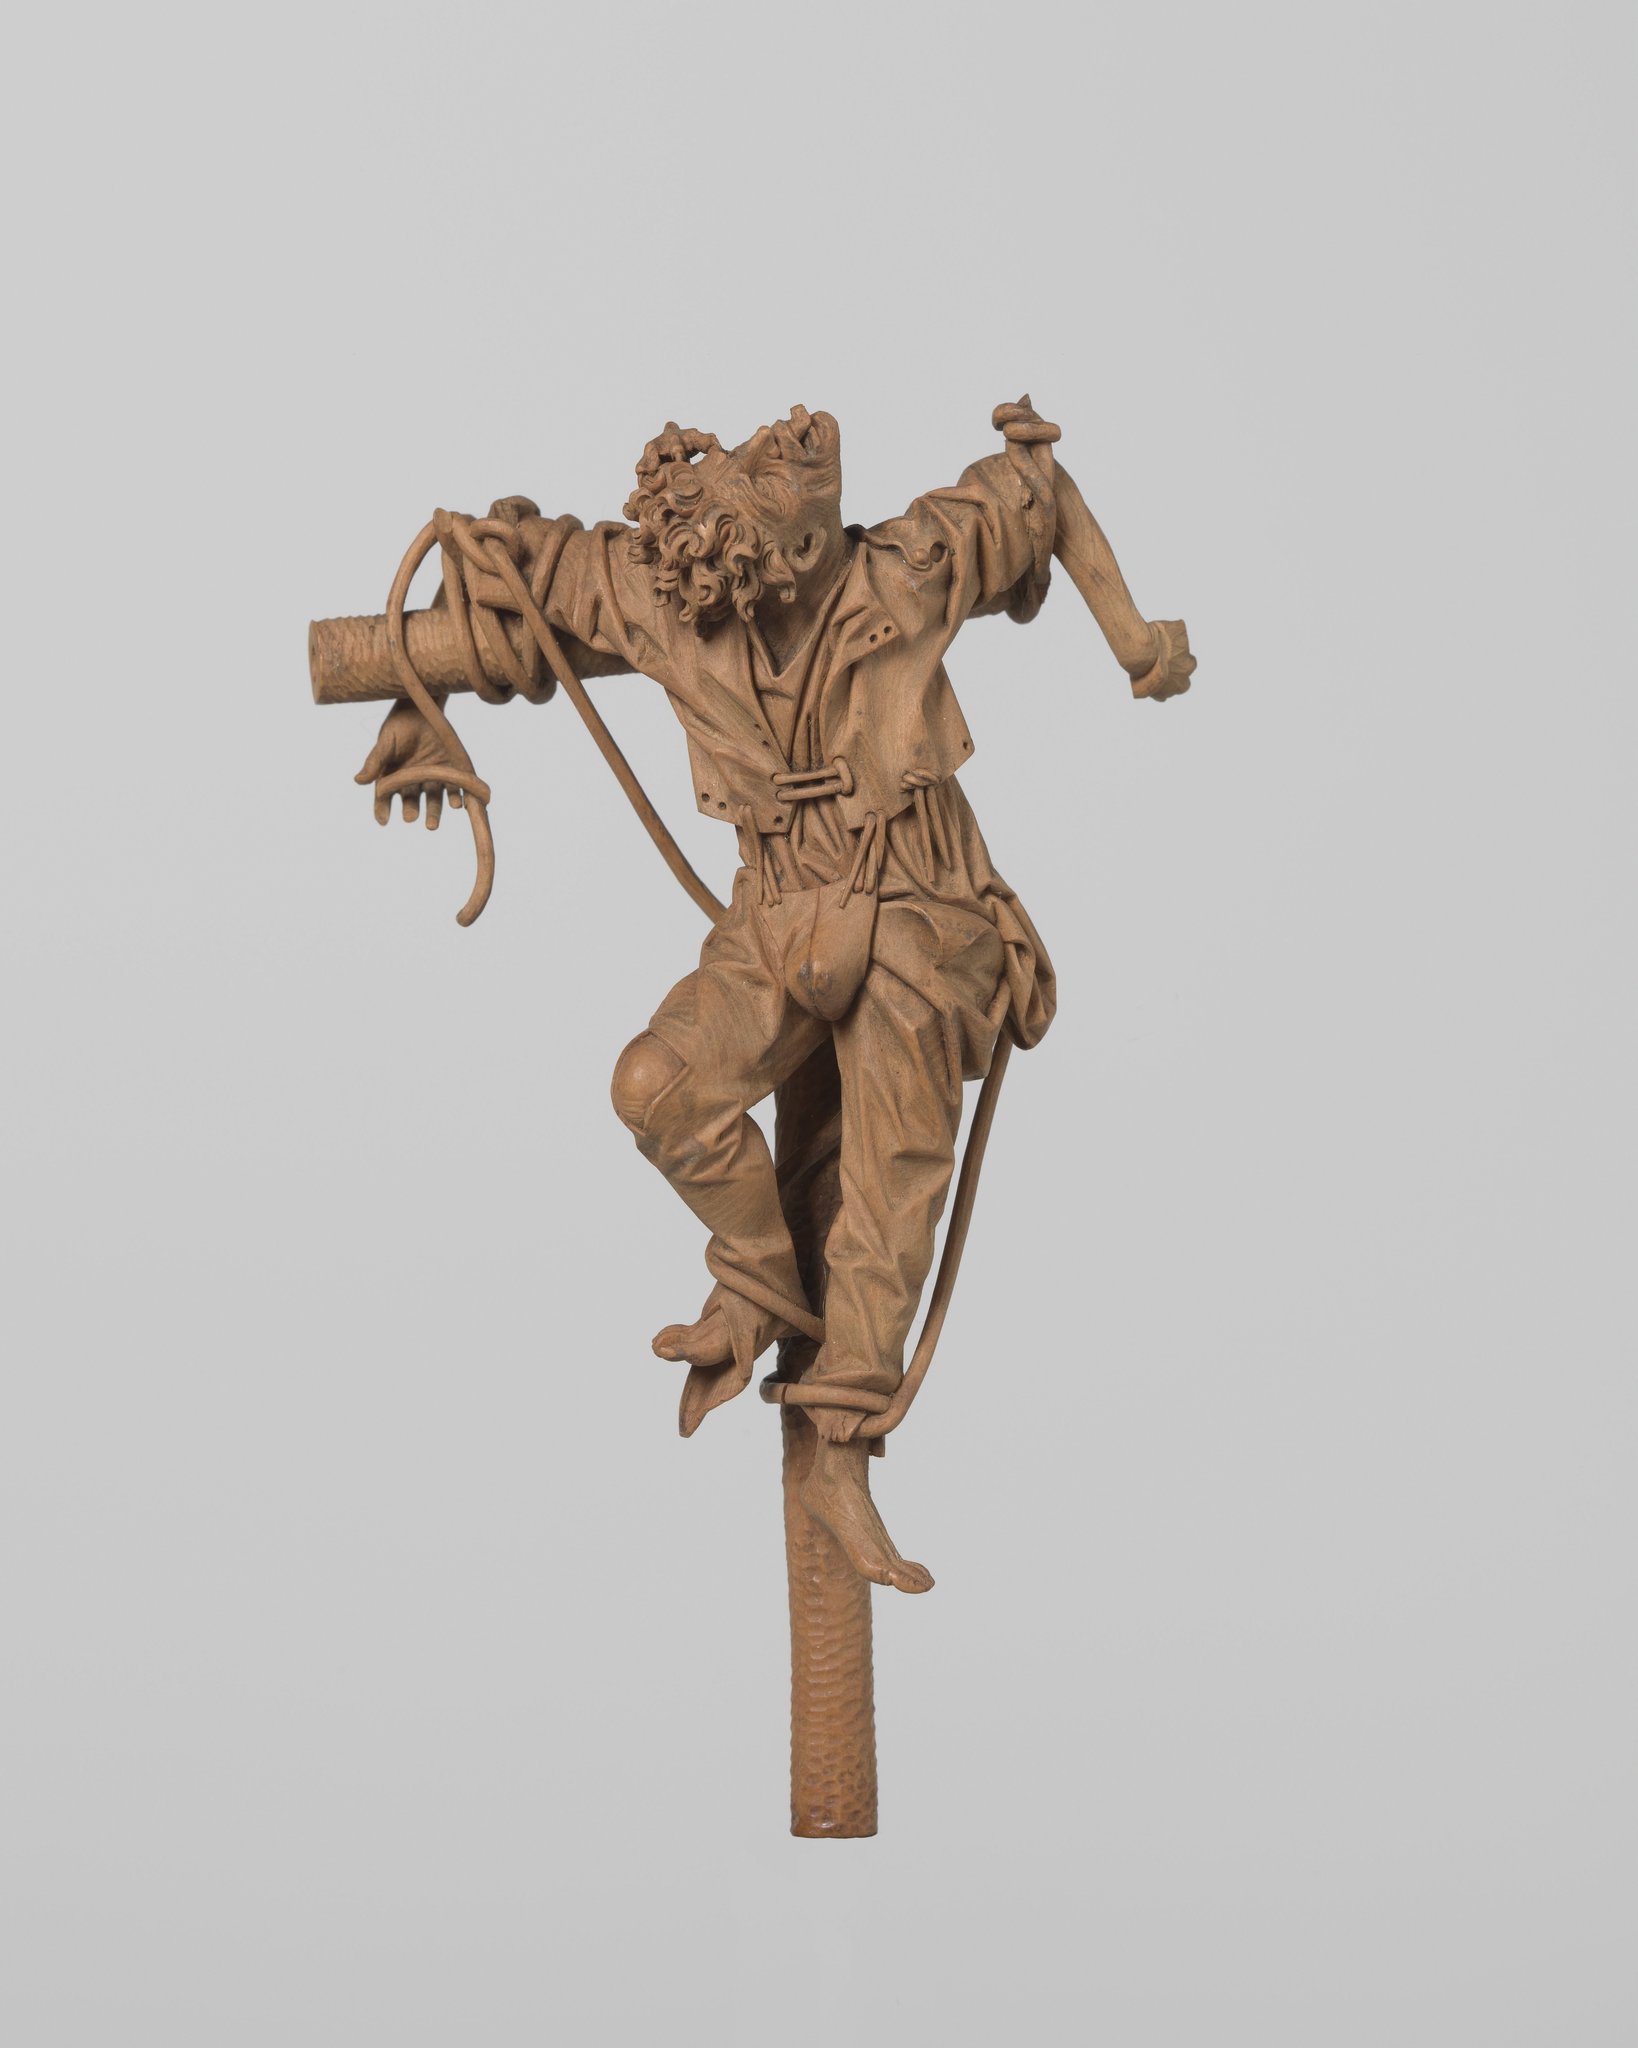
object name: sculpture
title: Gestas, the Bad Thief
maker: master of the kalkar st anne altarpiece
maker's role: sculptor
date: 1490-1510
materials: wood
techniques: cutting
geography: lower rhine region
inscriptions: inscription, on the bottom of the black, French-polished base, in white paint: ‘20563 / H. 258’ inventory nos. of the K.K. Österreichisches Museum für Kunst und Industrie in Vienna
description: De slechte moordenaar, Gestas, is in een getormenteerde houding opgehangen, met zijn verwrongen, baardeloze gezicht ooit afgewend van Christus en met geopende mond, waaruit zijn ziel door het nu ontbrekende duiveltje eruit wordt getrokken. Zijn armen zijn boven over het kruis heen gebogen en met een bundel koorden vastgezet. Zijn kleding is rijker dan die van Dysmas (BK-2014-20-1), met een gesloten jasje, dat met touw aan de voorzijde bijeengehouden wordt en eronder een hemd. Zijn lange kousen – zogenaamde hozen – zijn op de linkerknie gescheurd en onderaan steken zijn voeten eruit. Over zijn hozen draagt de man een braguette of schaamkap (‘kullezak‘) die met touwtjes aan zijn jas is gebonden.